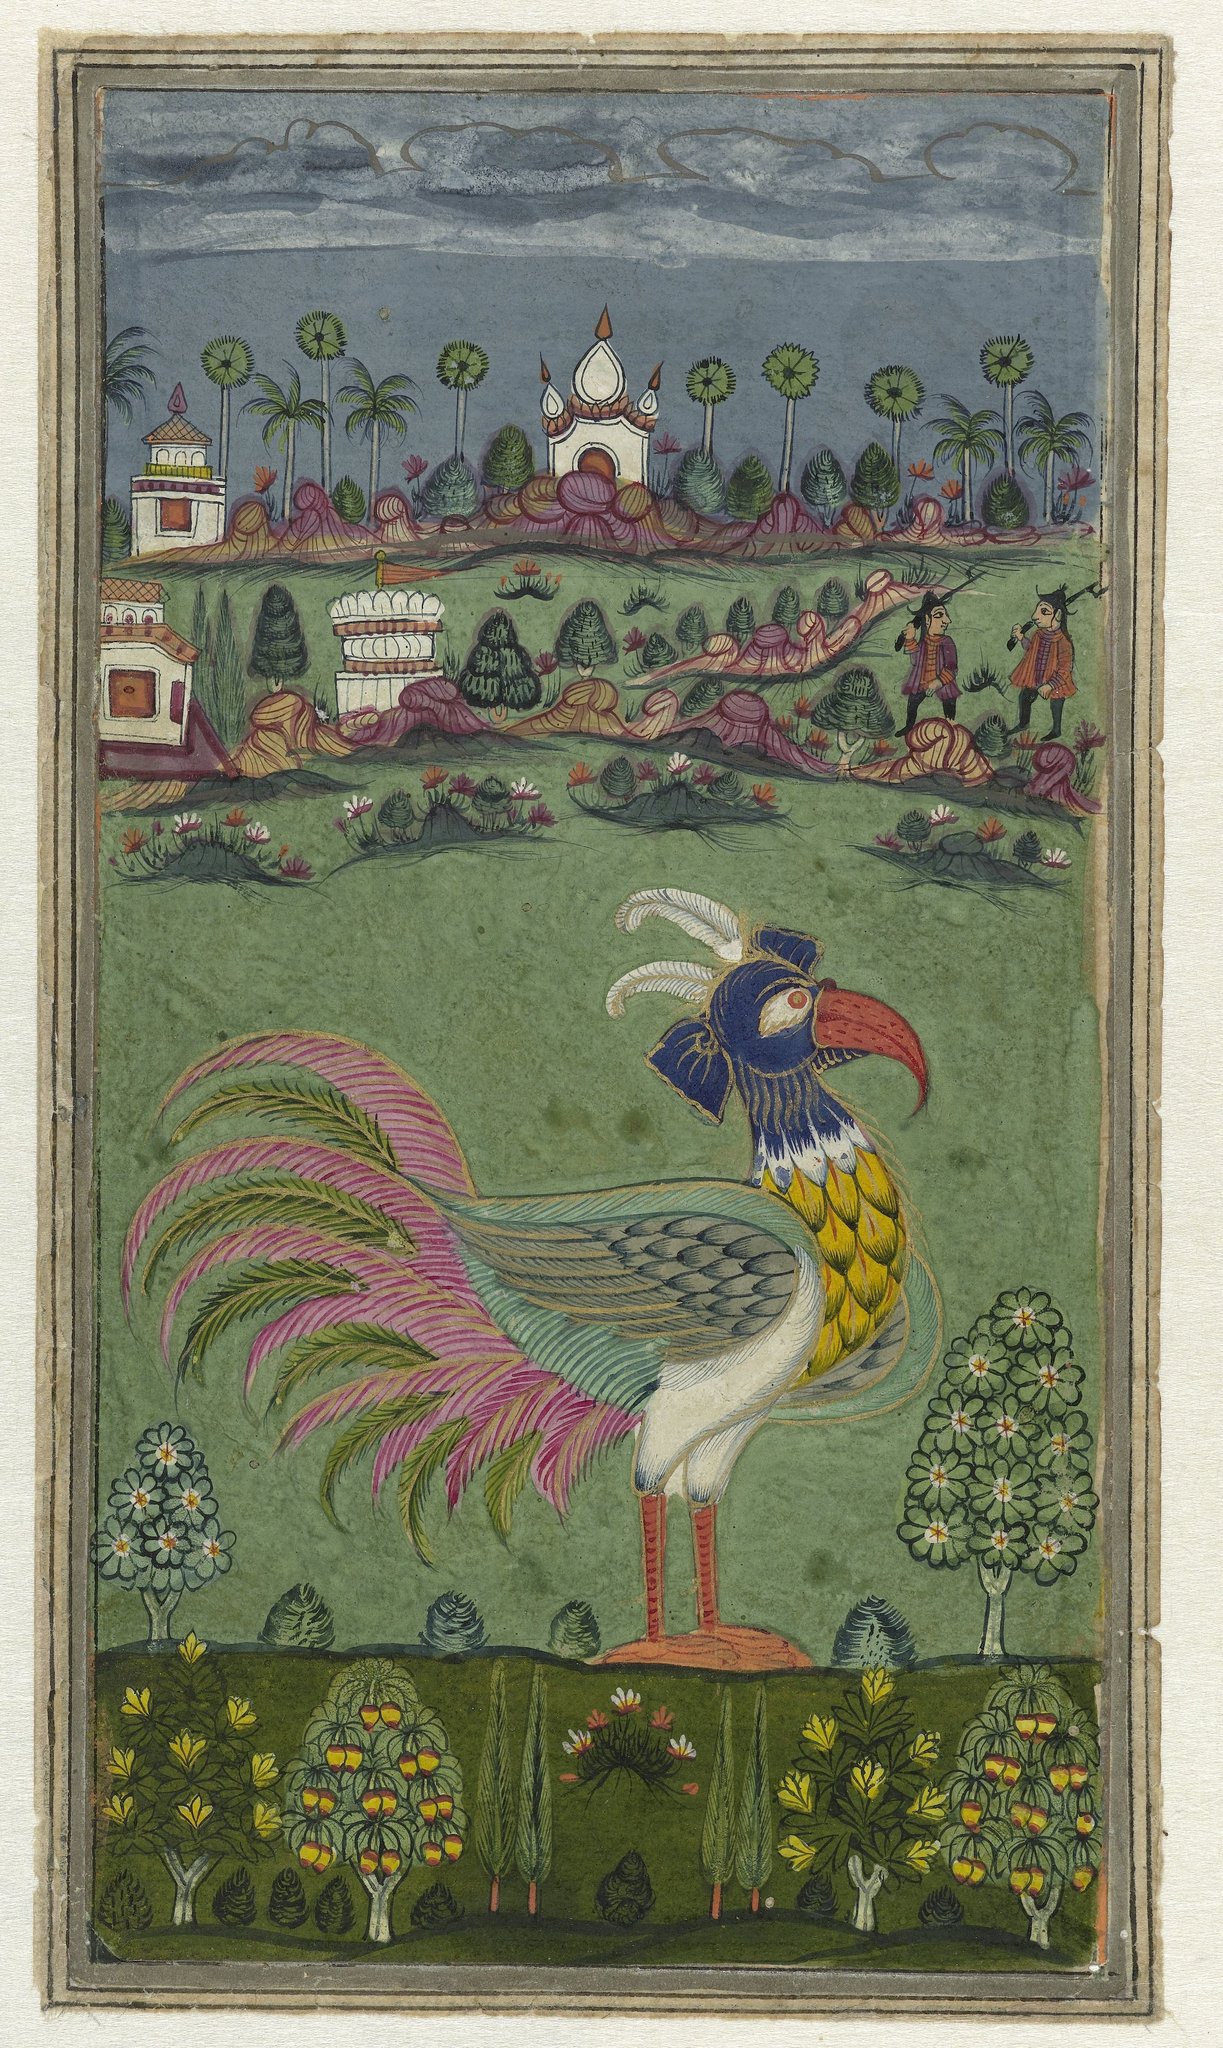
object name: drawing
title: Mythologische vogel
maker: Anonymous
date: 1750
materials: paper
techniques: brush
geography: deccan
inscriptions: inscription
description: Een kleurige gevederde vogel met kromme snavel staat tegen een achtergrond van donkergroen landschap; op de voorgrond een strook met bloeiende boompjes en tegen de donkergrijze lucht van de achtergrond een tempeltje en andere bouwwerken, hooibergen en twee boeren die met hooivorken over de schouder naar het dorp terugkeren. De voorstelling is opgeplakt op een smal strookje en omrand met kaderlijnen in zwart, de binnenste lijnen zijn met penseel in grijs ingekleurd.